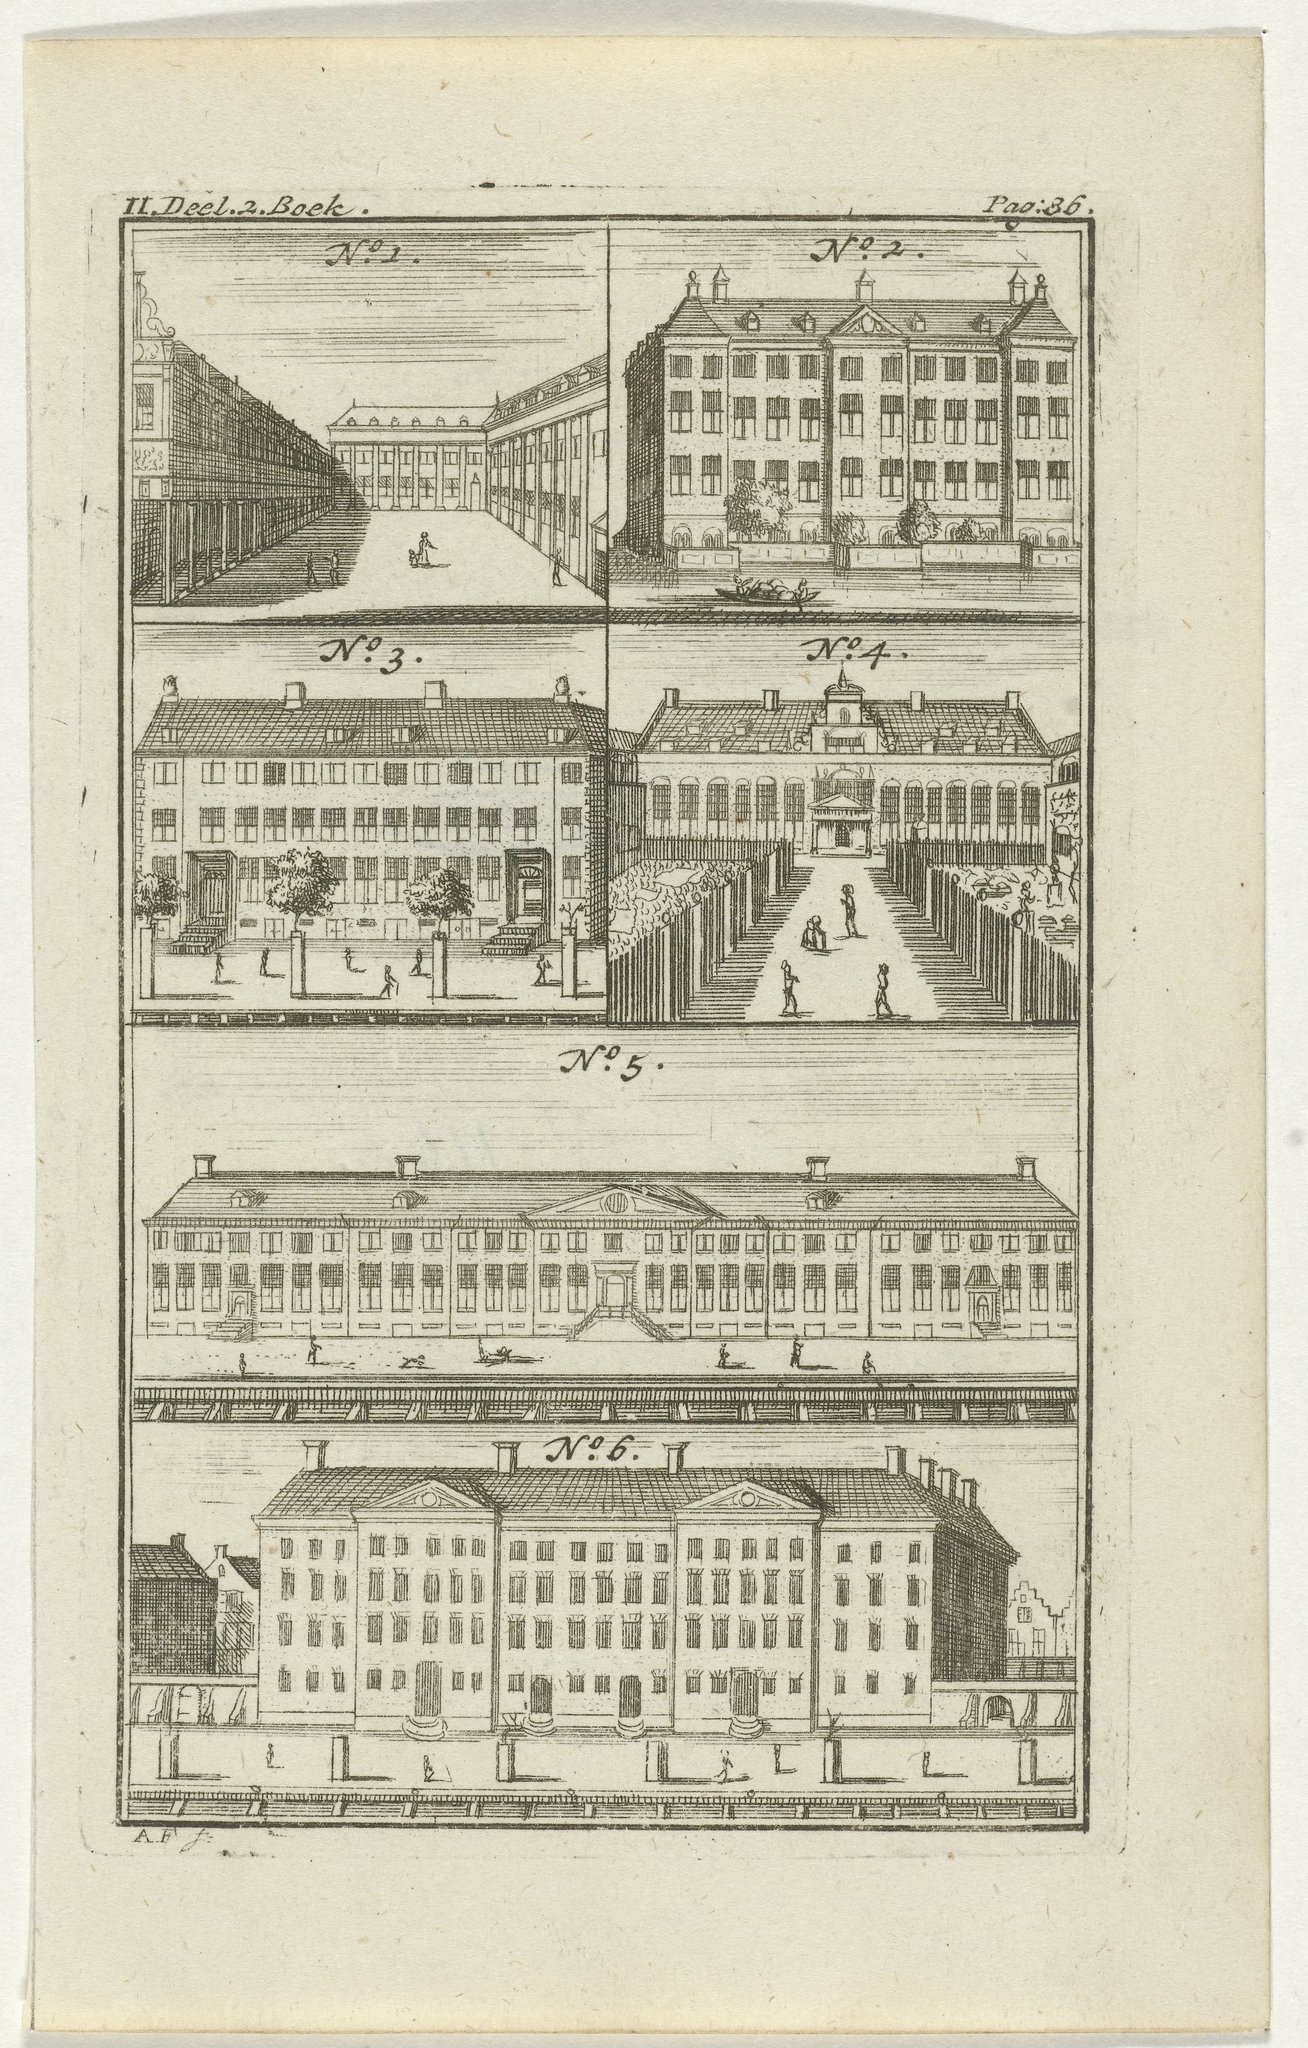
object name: text sheet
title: Tekstblad bij boekillustratie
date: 1723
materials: paper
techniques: letterpress printing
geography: amsterdam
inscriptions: collector's mark: Lugt 2760, collector's mark: Lugt 2228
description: Tekstblad uit: Leuve, Roeland van. 's Waerelds koopslot of De Amsteldamse beurs. Amsterdam: Jacobus Verheyden (I), 1723.